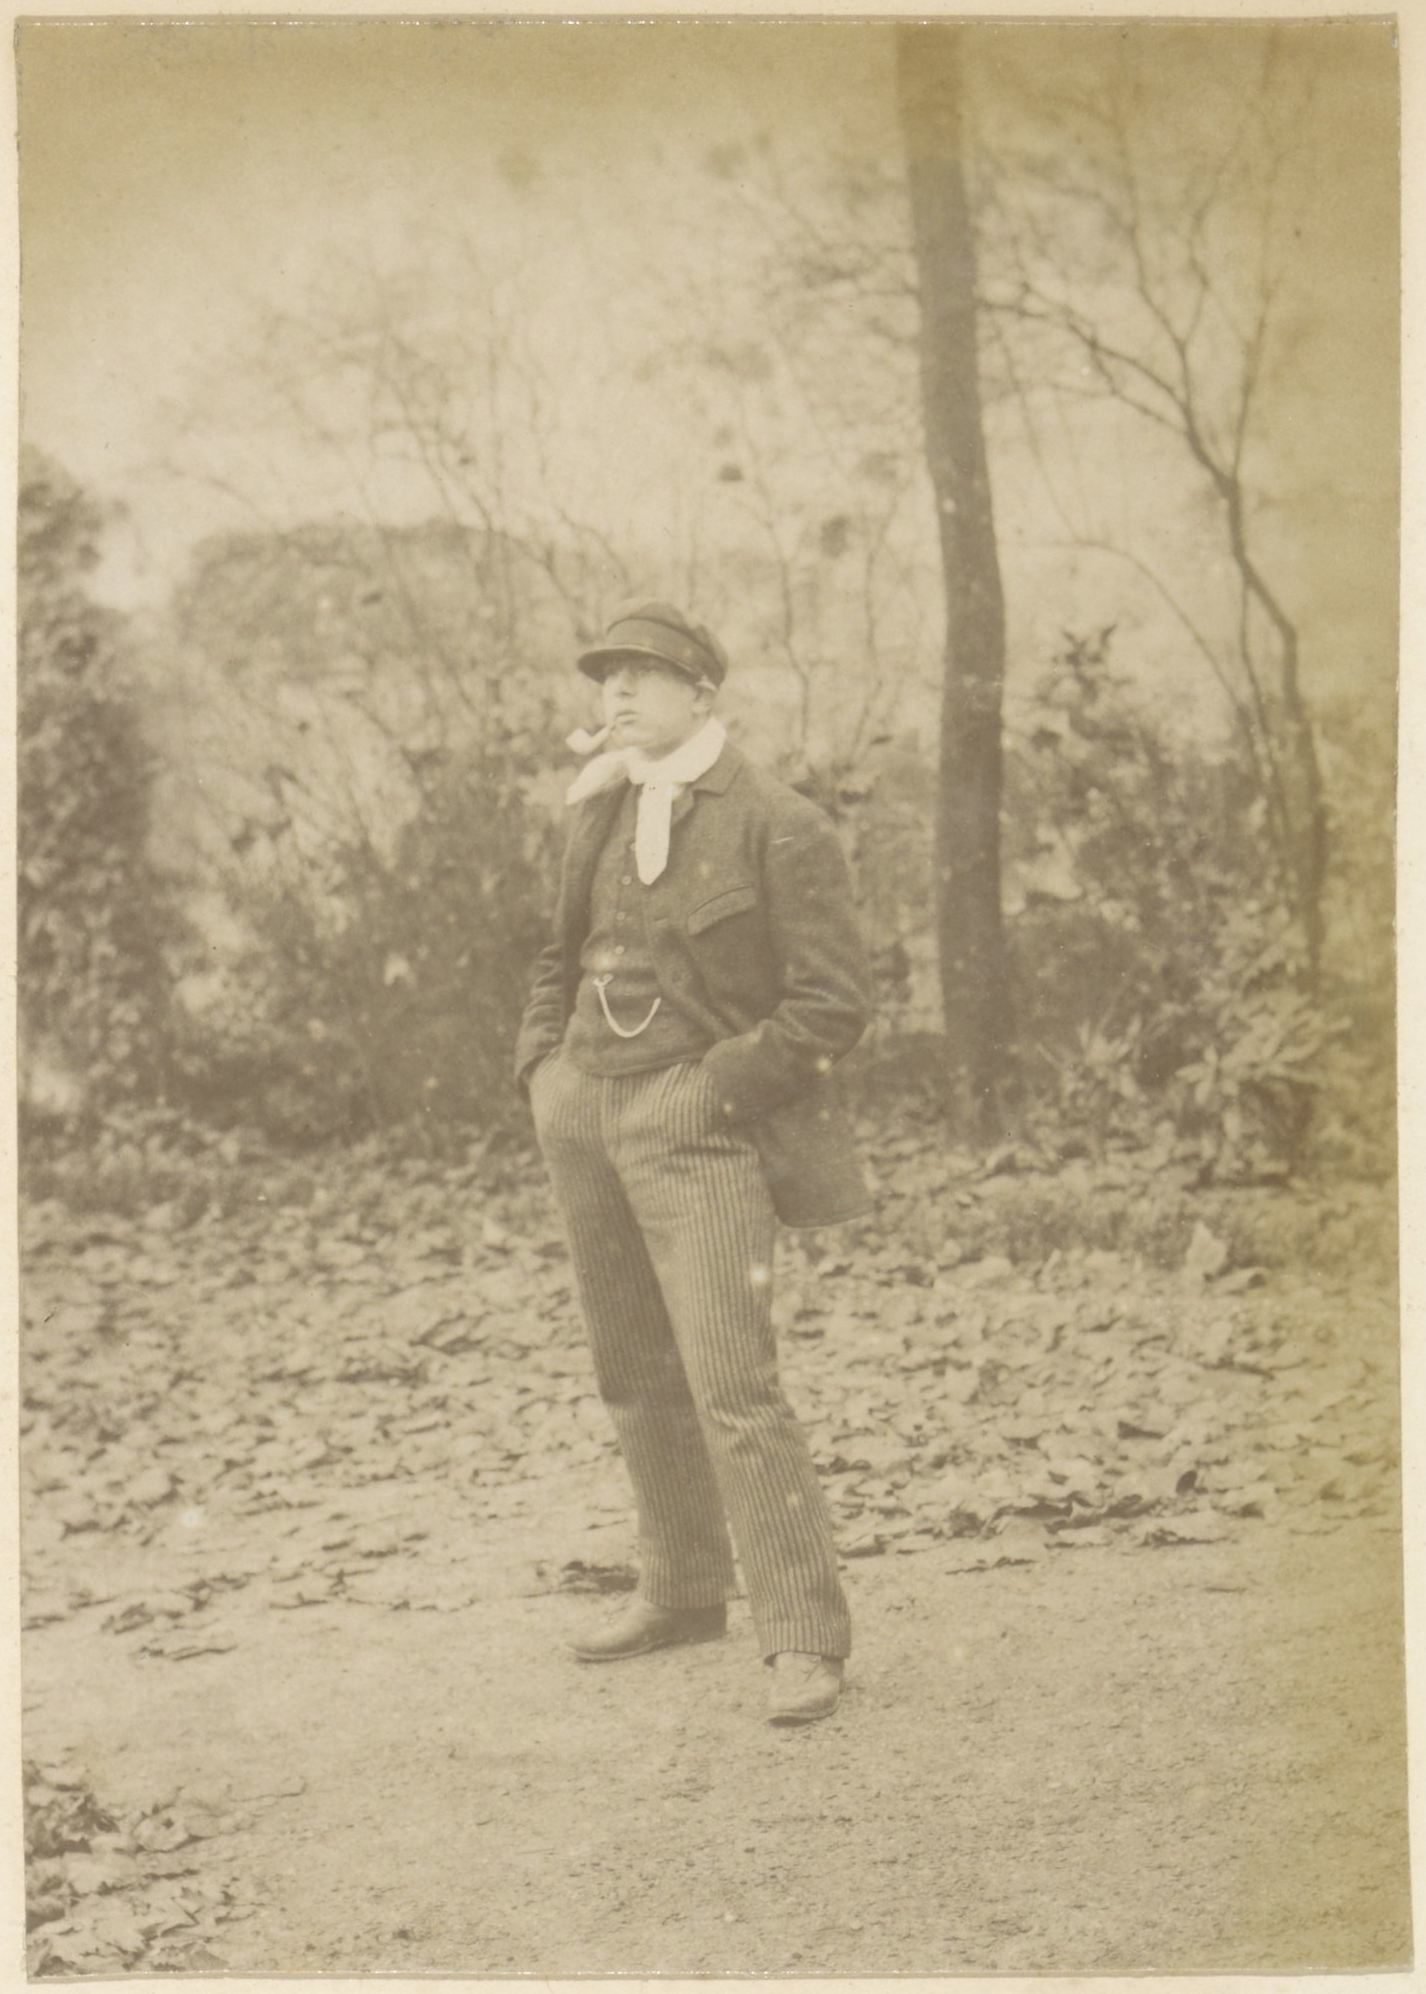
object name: photograph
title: Portret van een Franse jongeman met pijp en pet, zijn handen in de zakken houdend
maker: Anonymous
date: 1900-1910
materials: paper, photographic support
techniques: albumen print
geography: france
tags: hand in the pocket - aa - both arms or hands, youth, adolescent, pipe ~ tobacco, head-gear: cap, france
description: Onderdeel van Fotoalbum van een Franse amateurfotograaf met opnames van een familie, distilleerderij Delizy & Doistau Fils, het leger en bezienswaardigheden in Frankrijk.